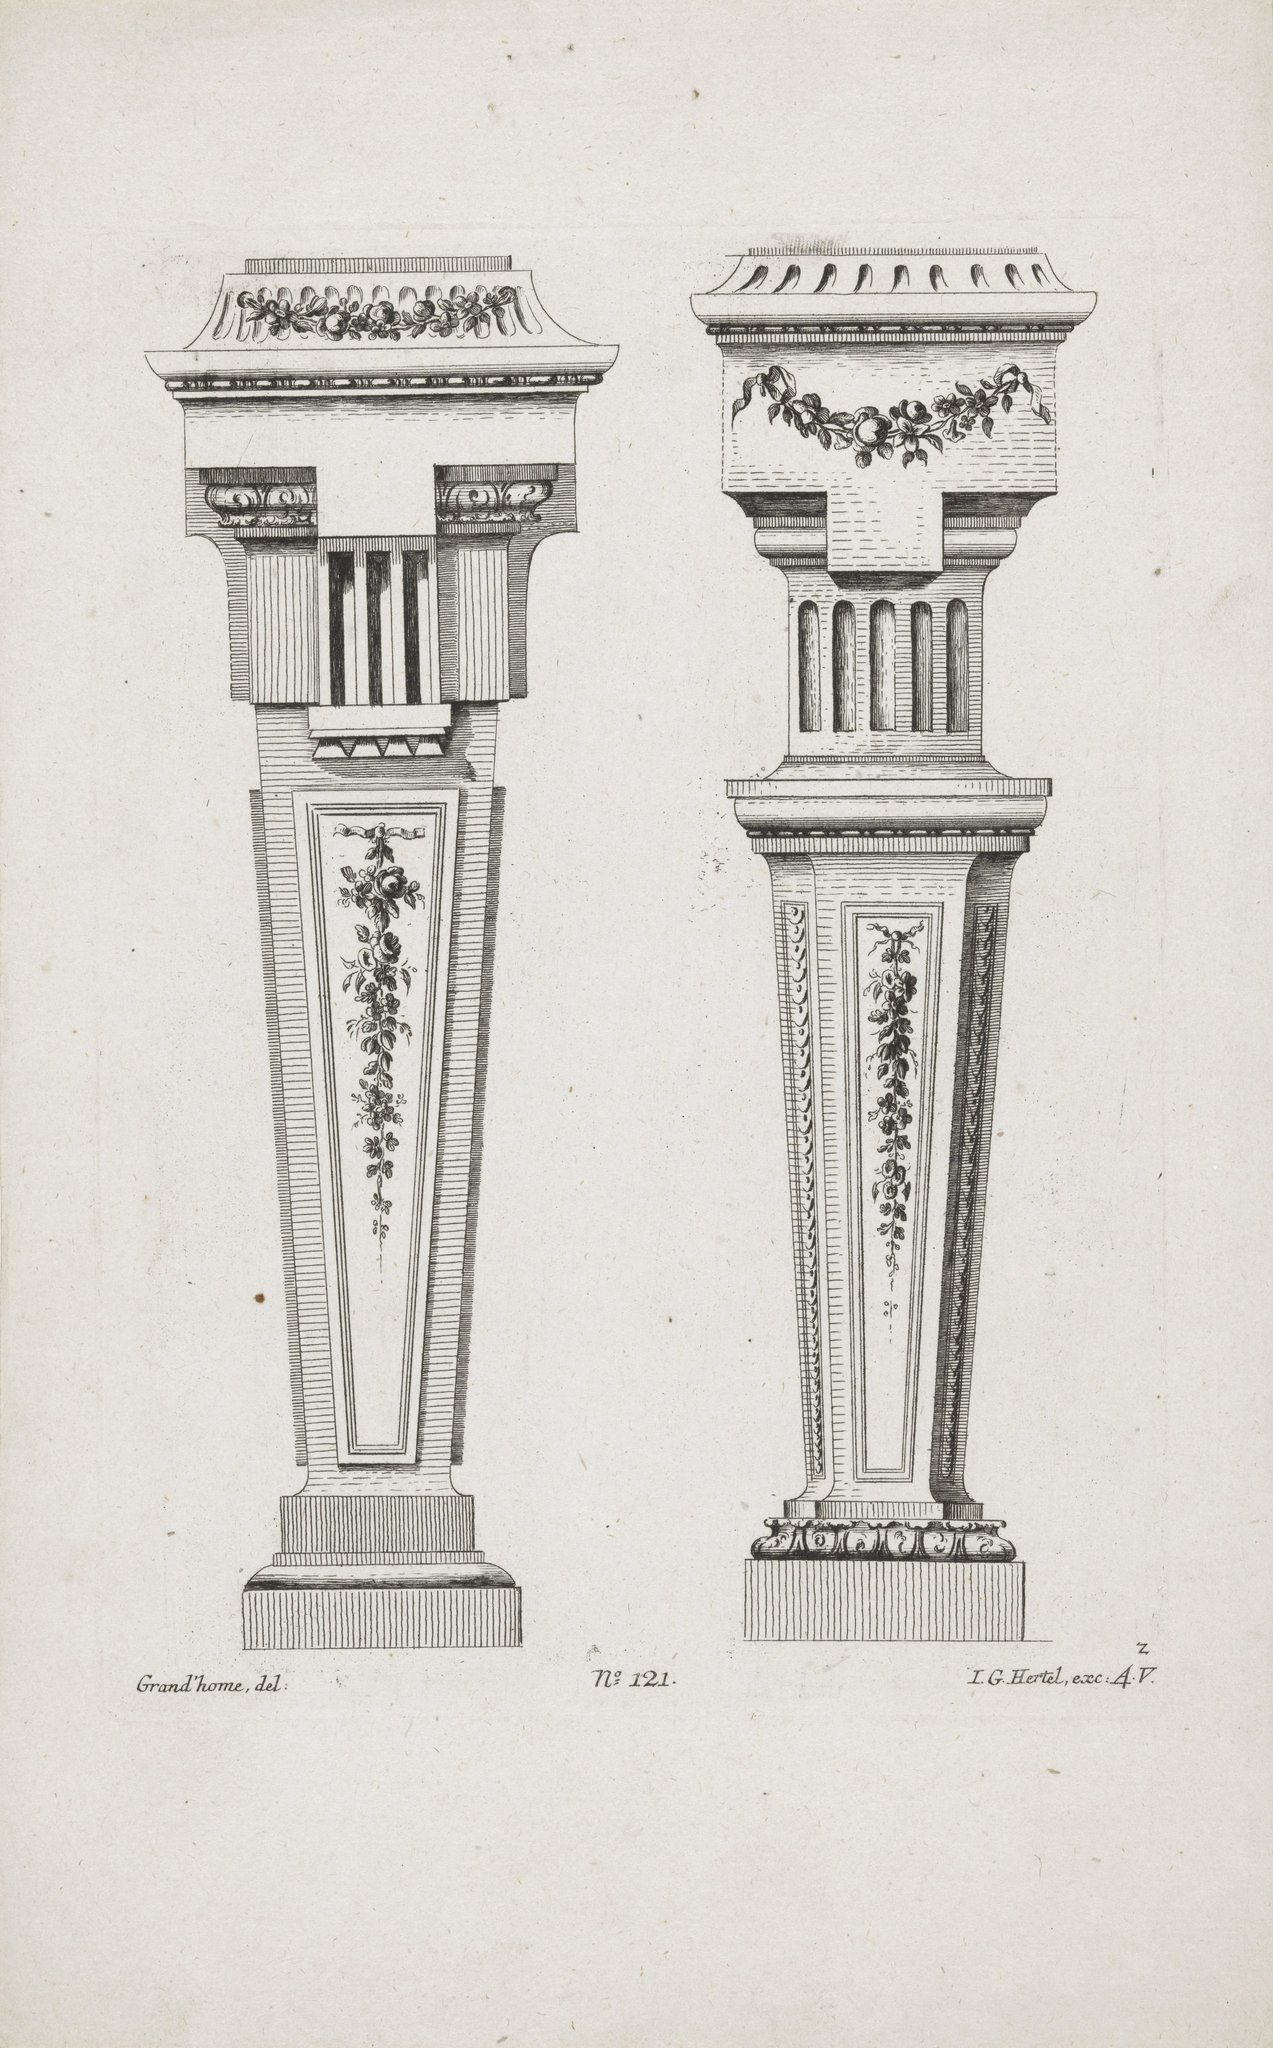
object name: ornament print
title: Ontwerpen voor voetstukken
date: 1751-1775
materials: paper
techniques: etching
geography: augsburg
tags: tendrils ~ ornament, pedestal of a piece of sculpture (perhaps in the form of a herm), ornament ~ festoon, garland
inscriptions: collector's mark: Lugt 2228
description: Twee voetstukken met guirlandes en bloemenranken. Uitgeversnummer 121.